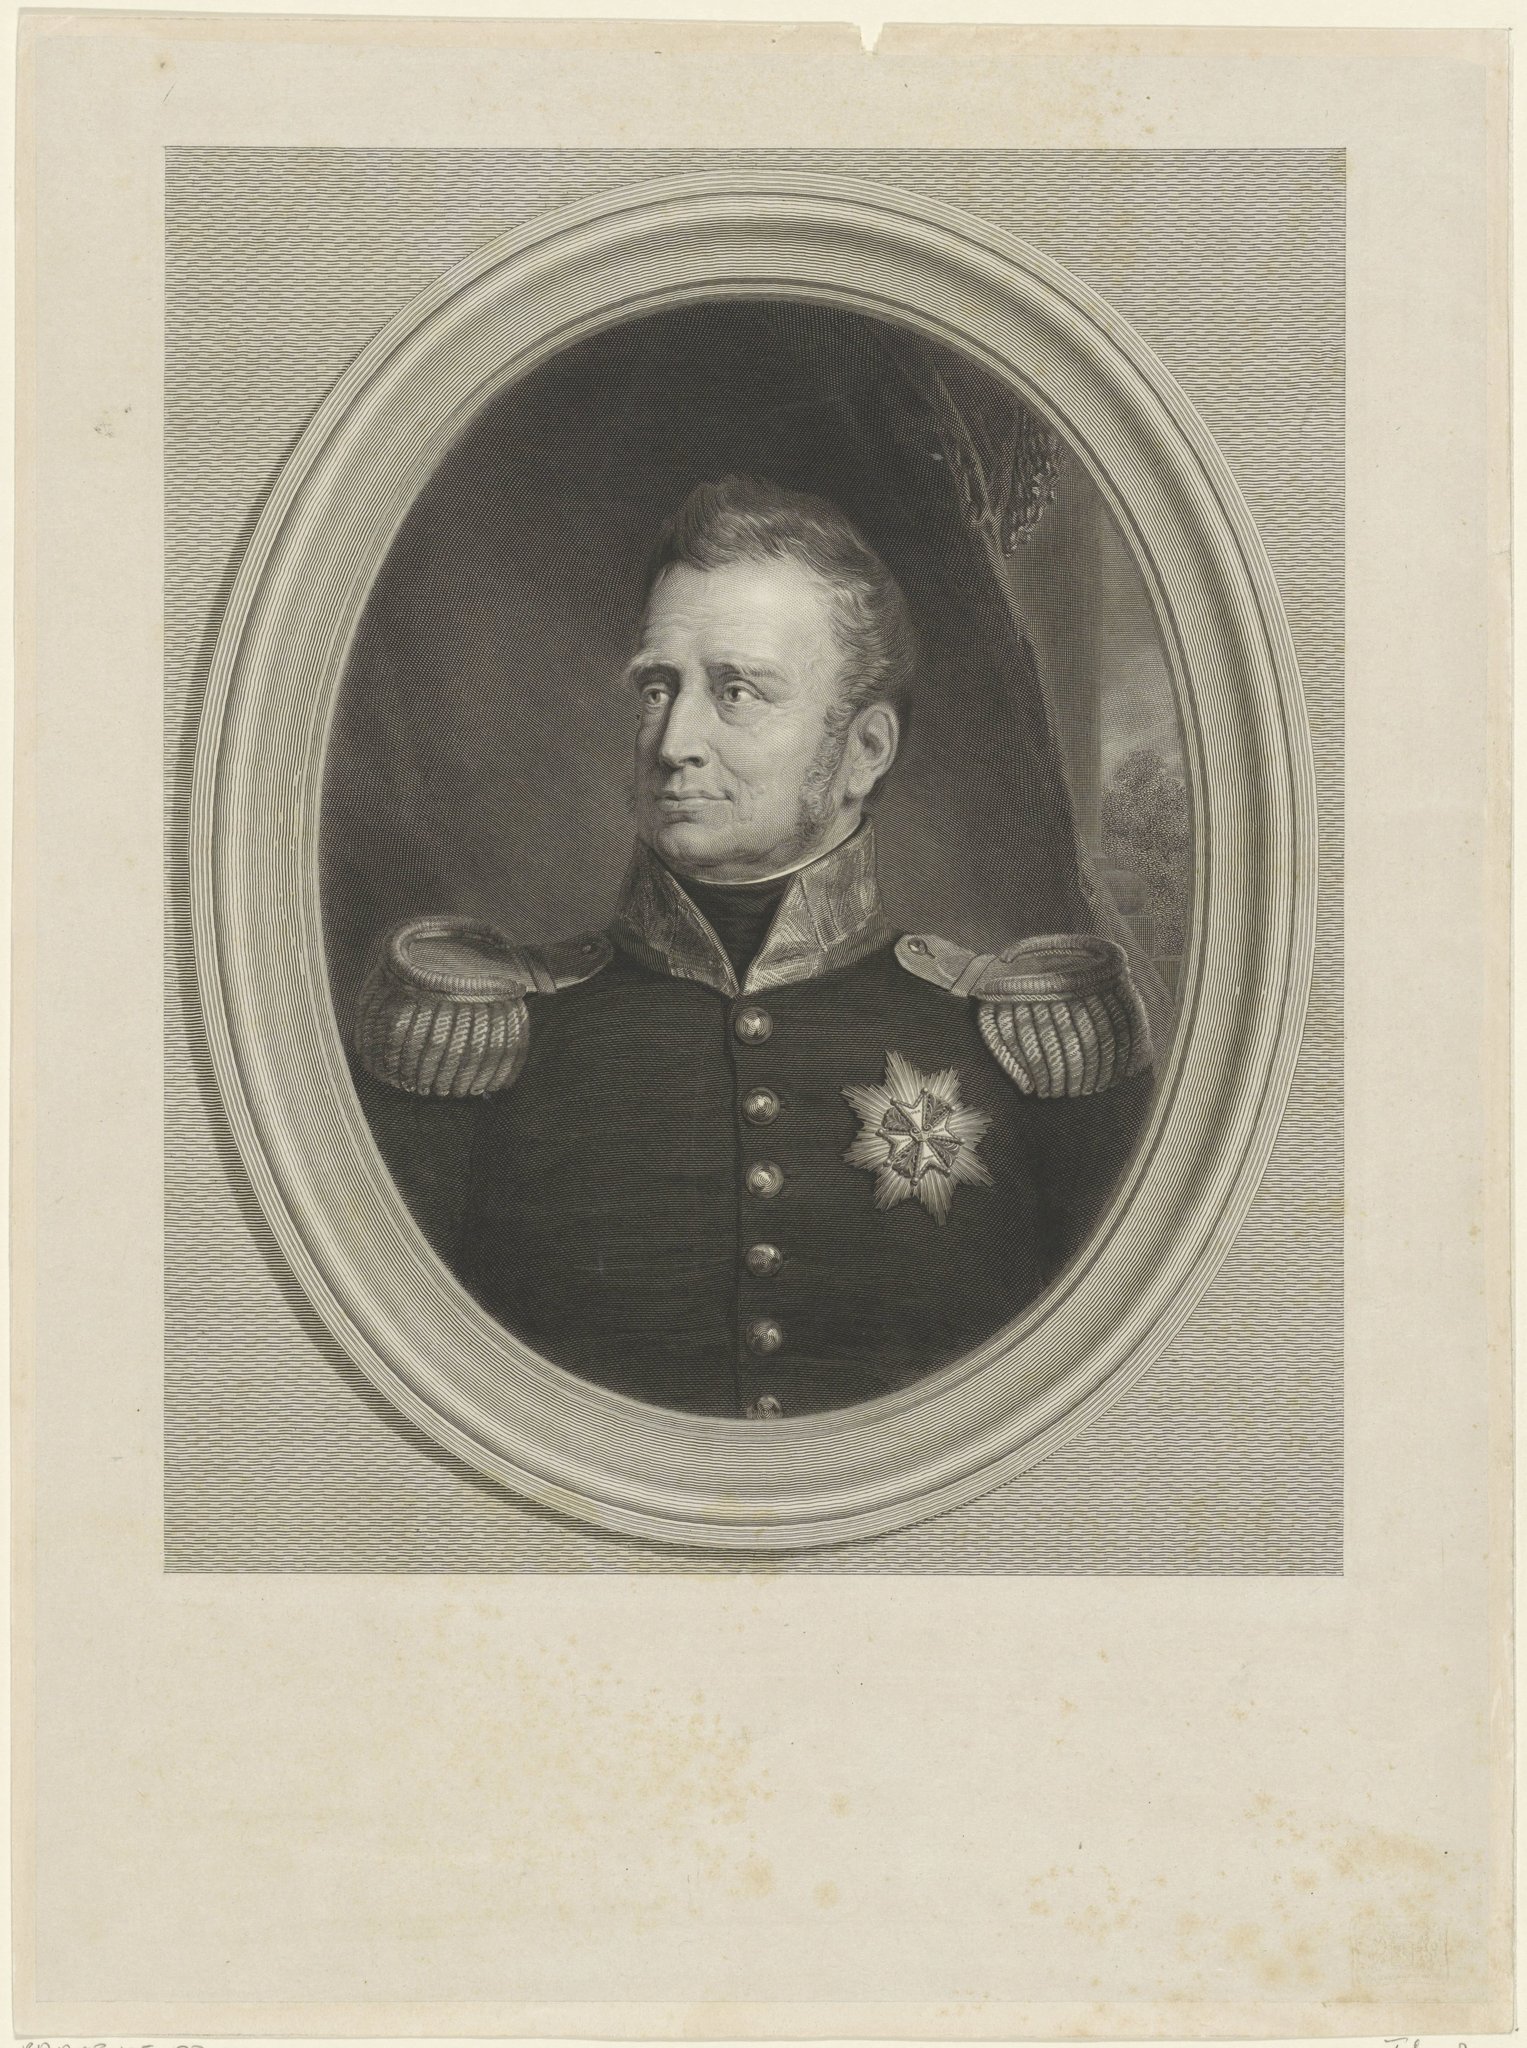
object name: print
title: Portret van Willem I Frederik, koning der Nederlanden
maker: benoit taurel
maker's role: draughtsman, print maker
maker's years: 1794-1859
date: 1831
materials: paper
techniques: engraving, etching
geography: amsterdam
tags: the hague, berlin, william i of the netherlands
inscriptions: check stamp: ‘François Buffa & Fils’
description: De hier vermelde titel verwijst naar de hoogst verkregen titel van de geportretteerde, niet per se naar de titel die de geportretteerde op deze voorstelling draagt.